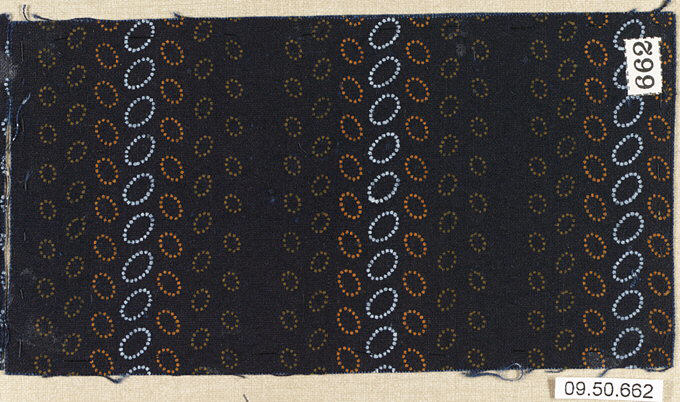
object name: piece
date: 1801-1900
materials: cotton